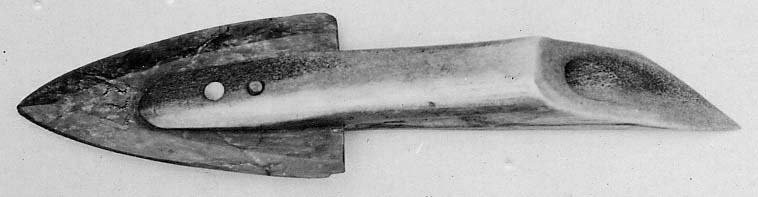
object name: harpoon head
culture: north american, alaskan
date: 1902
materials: jade